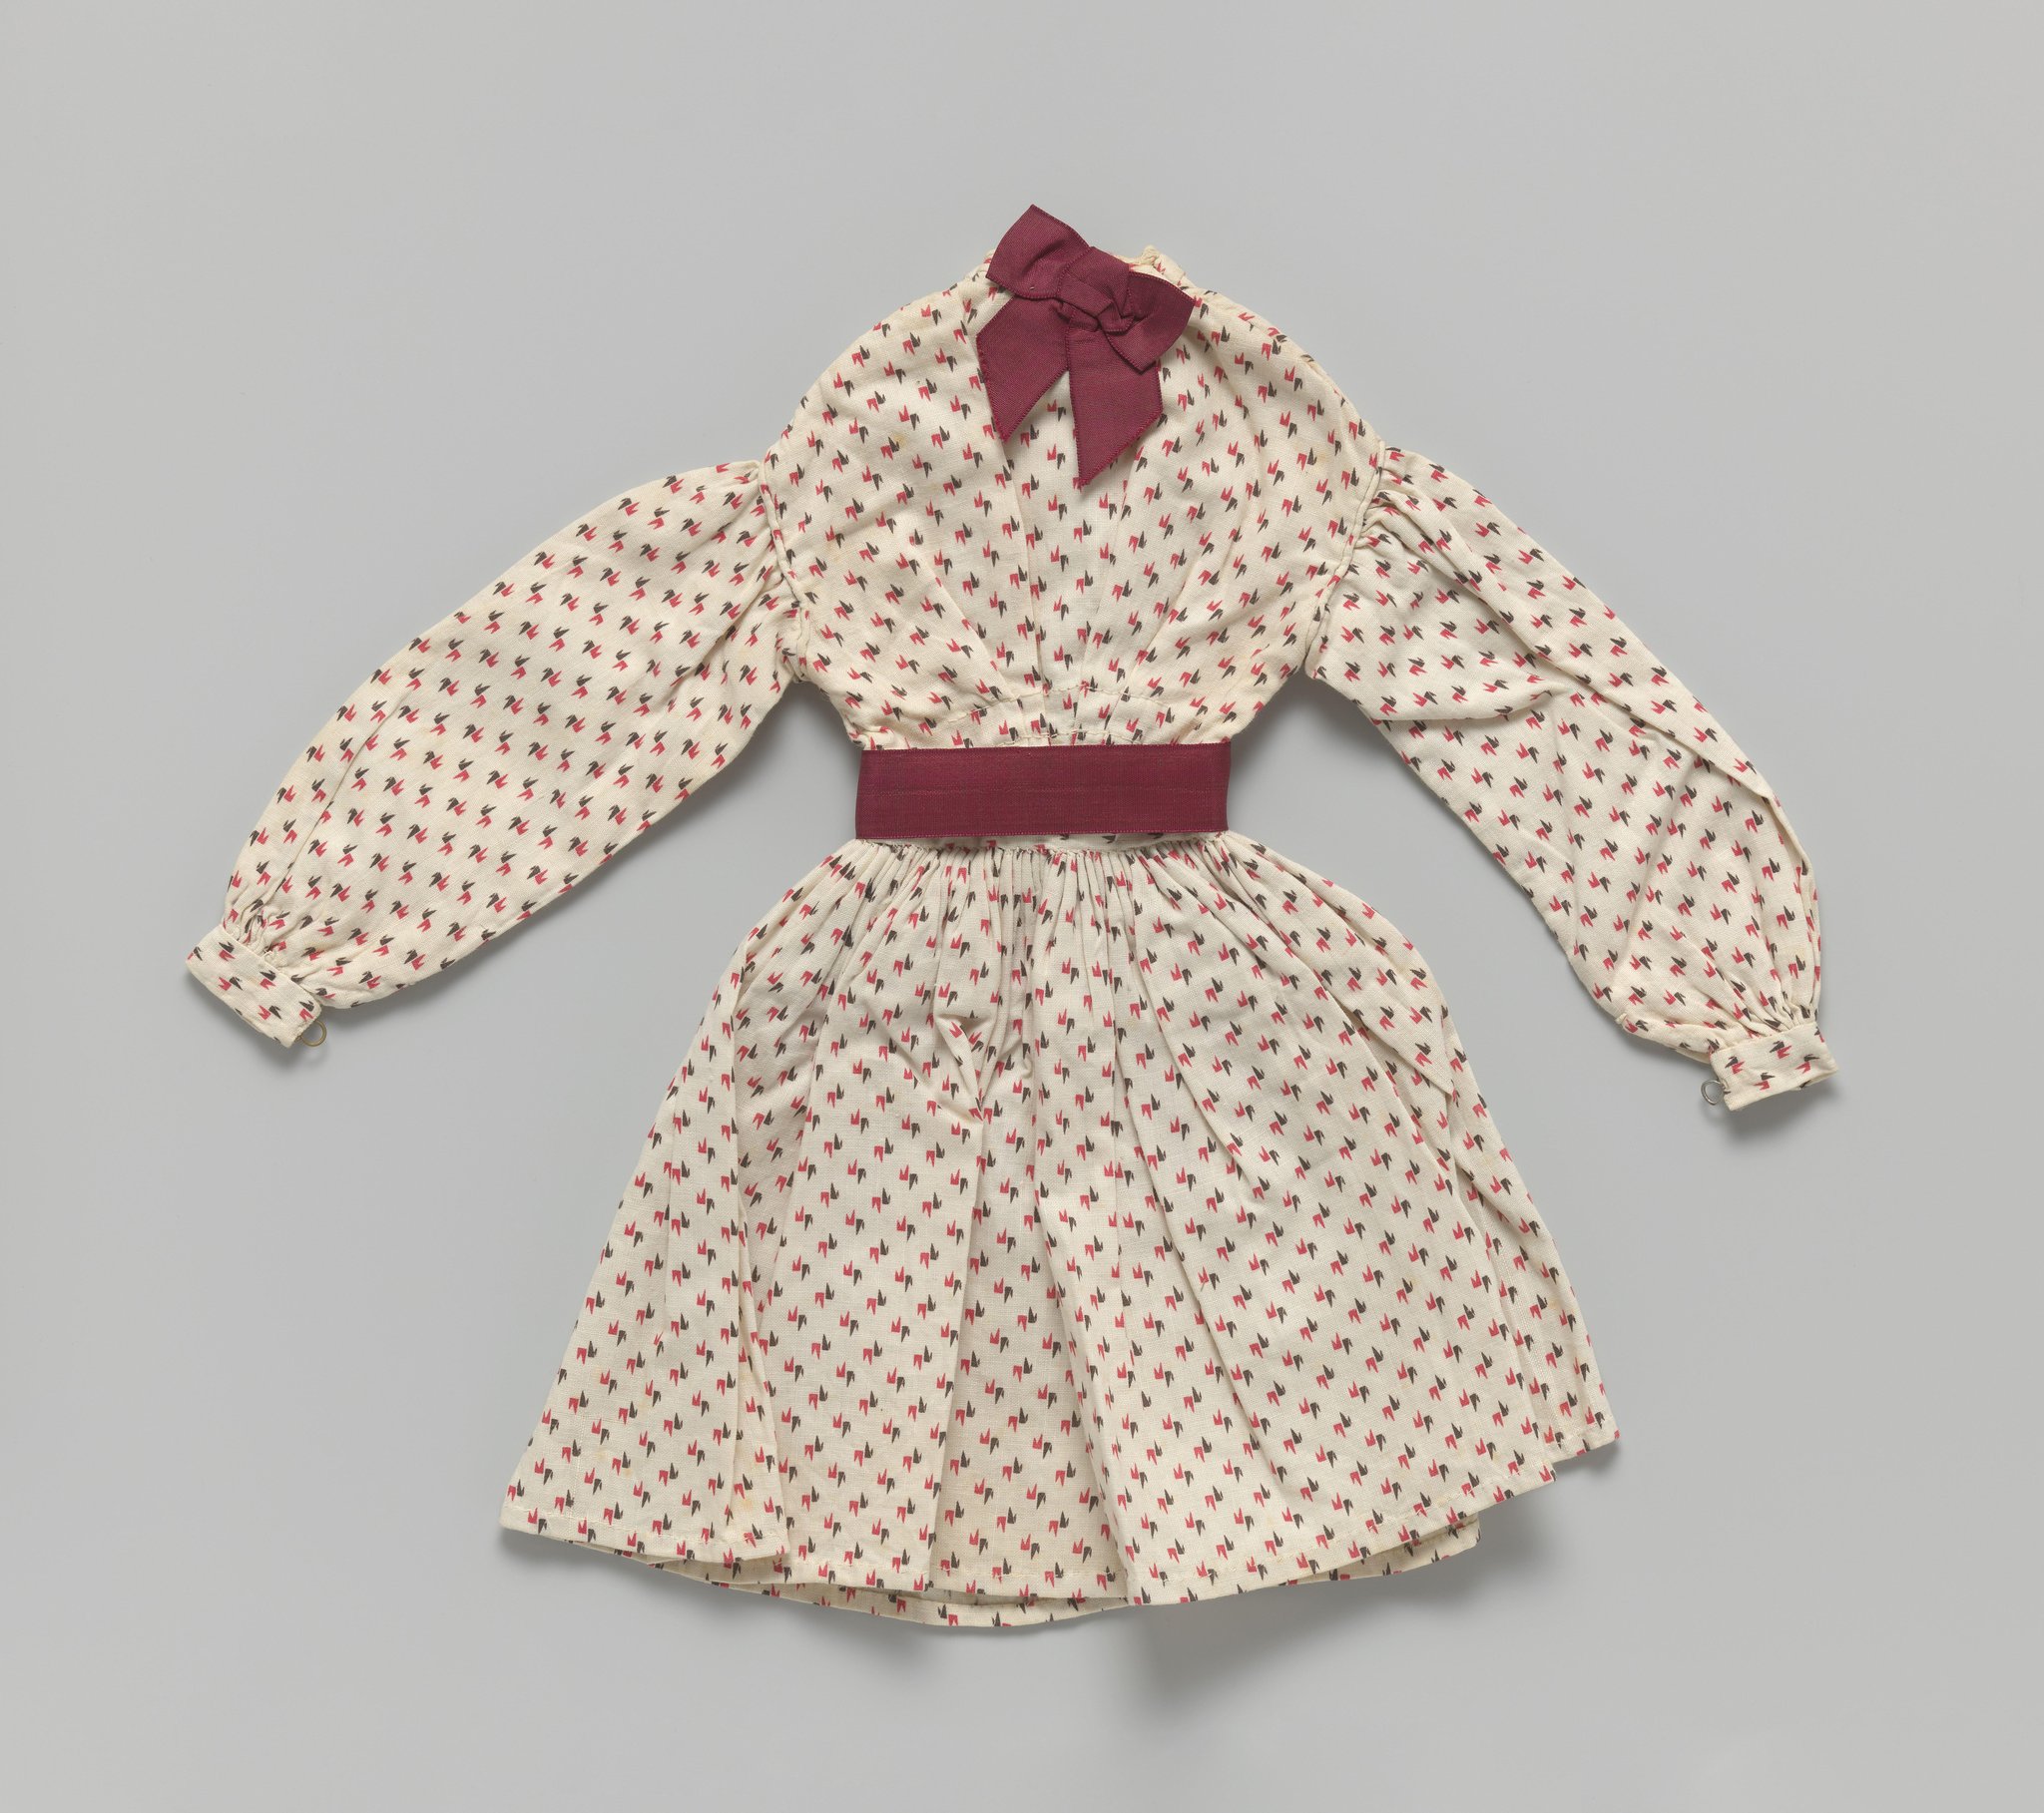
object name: robe, japon, jurk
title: Japon van wit katoen berdukt met motief in zwart en rood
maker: Anonymous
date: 1850-1920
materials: cotton, metal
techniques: printing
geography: europe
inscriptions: number: ‘RBK15445’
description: Rond de taille en op de hals een bordeauxrode lint. De gestrikte ceintuur heeft aan de uiteinden een rond stuk kant. Het lijfje sluit net als de manchetten met haken en ogen van metaal.